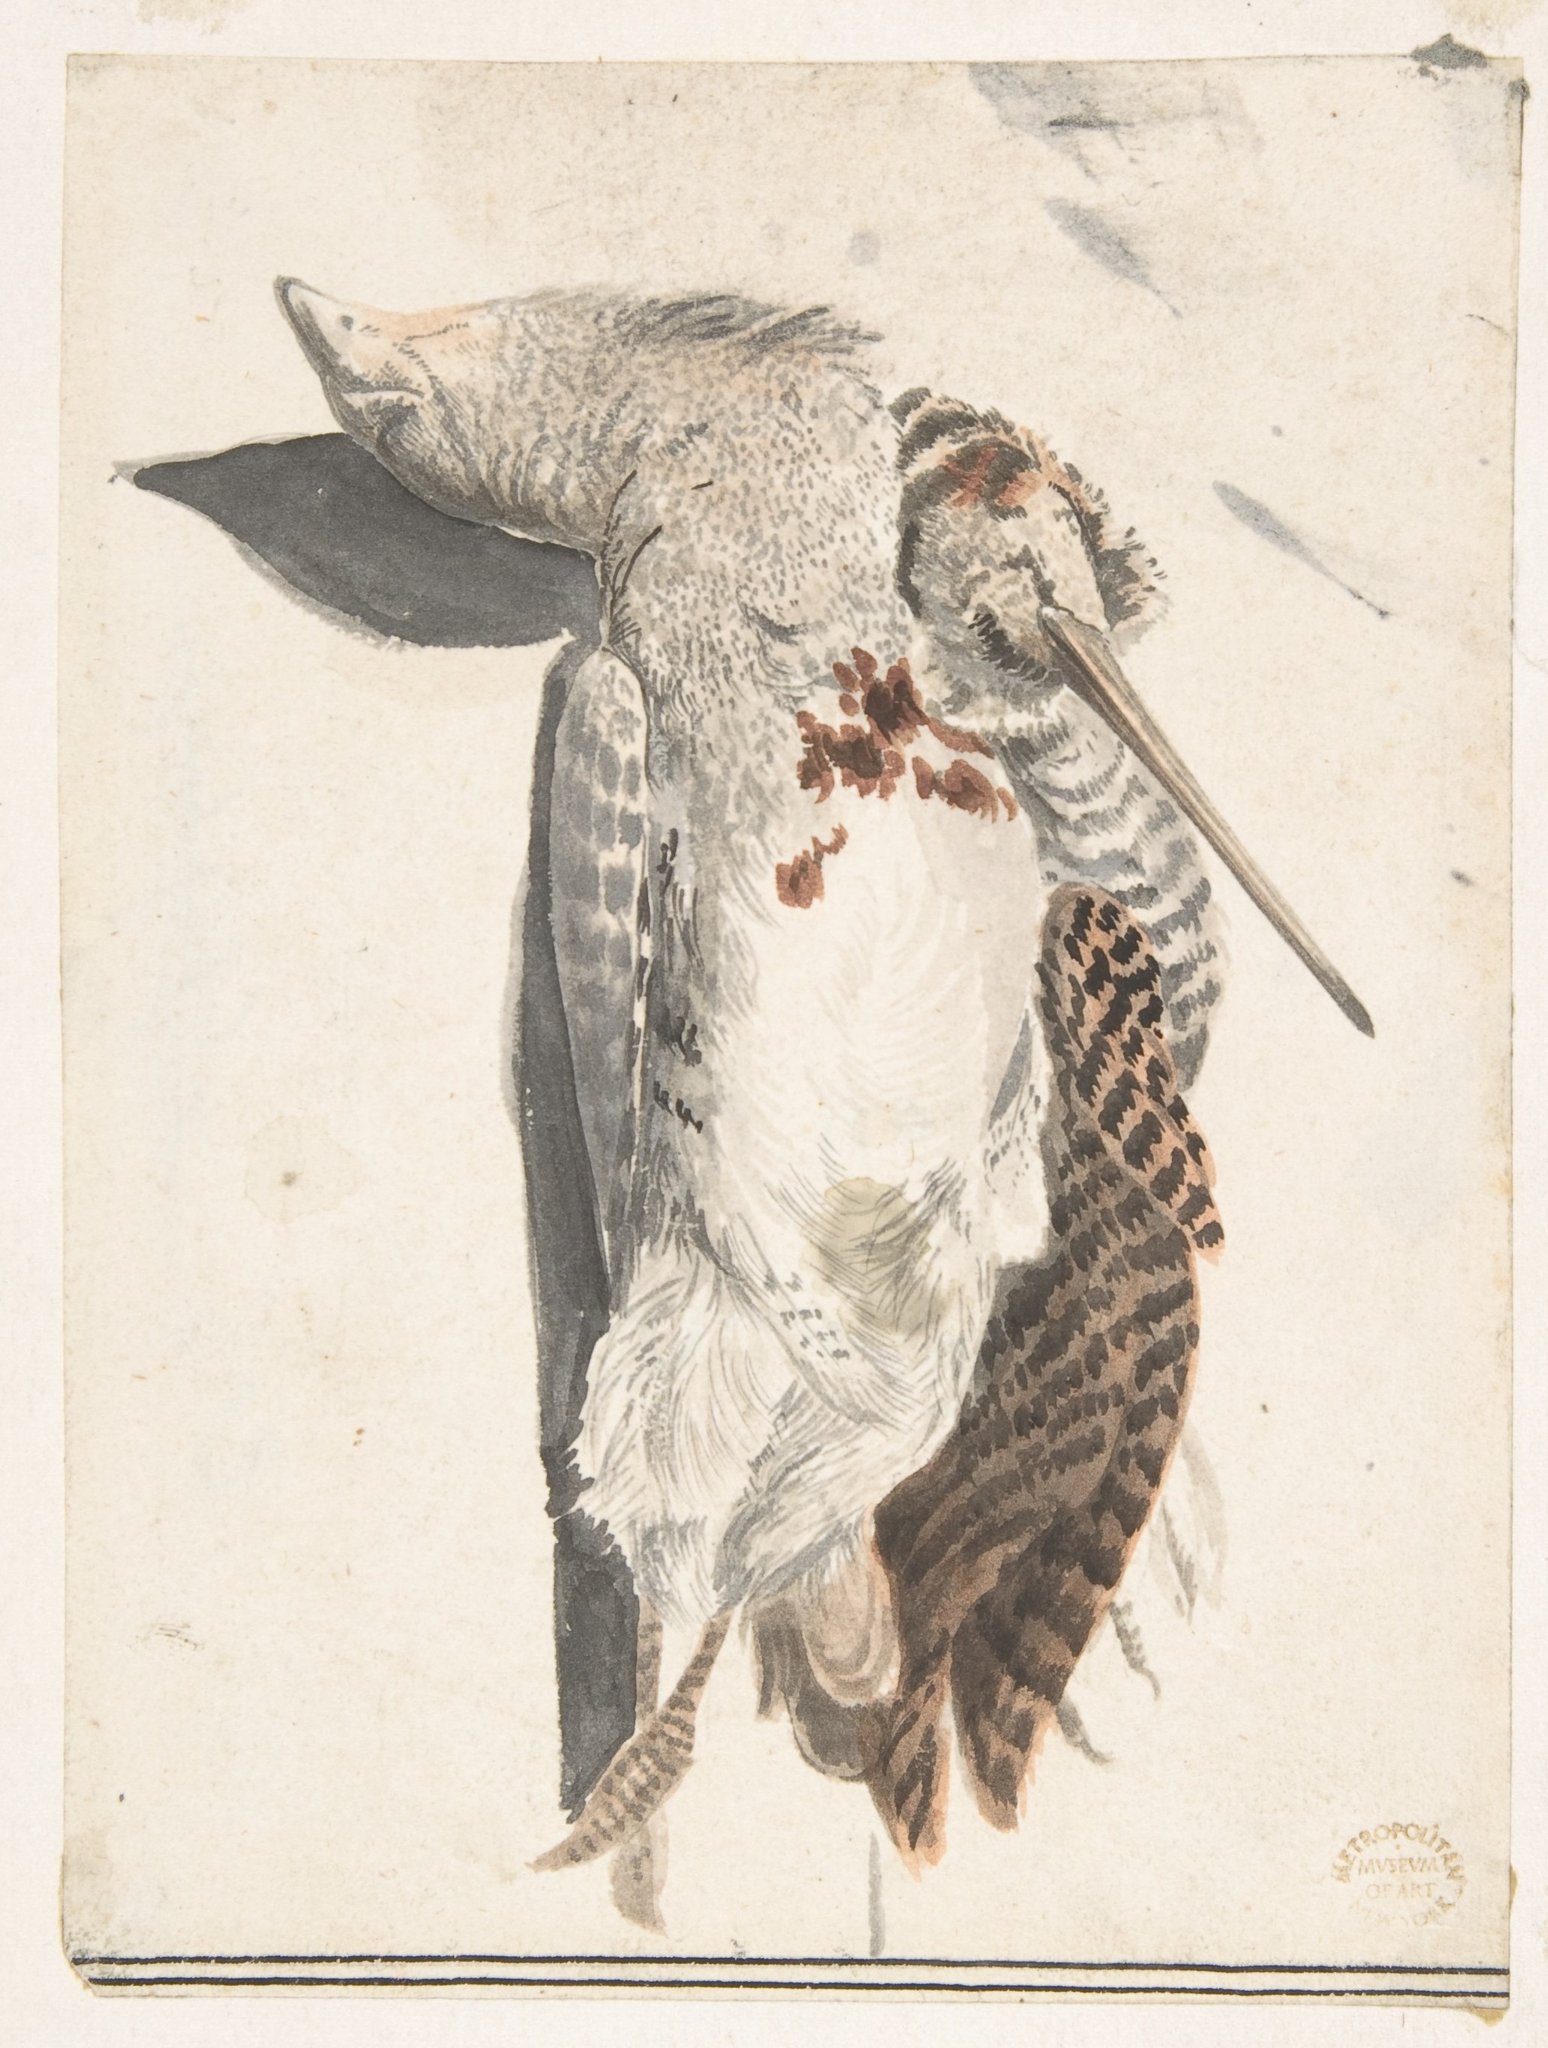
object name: drawing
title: Two Dead Birds (A Quail and a Long-Beaked Bird)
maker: count giorgio durante (duranti)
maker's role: artist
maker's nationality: italian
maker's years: 1685-1755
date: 1705-1755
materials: graphite, ink, watercolor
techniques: pen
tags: birds